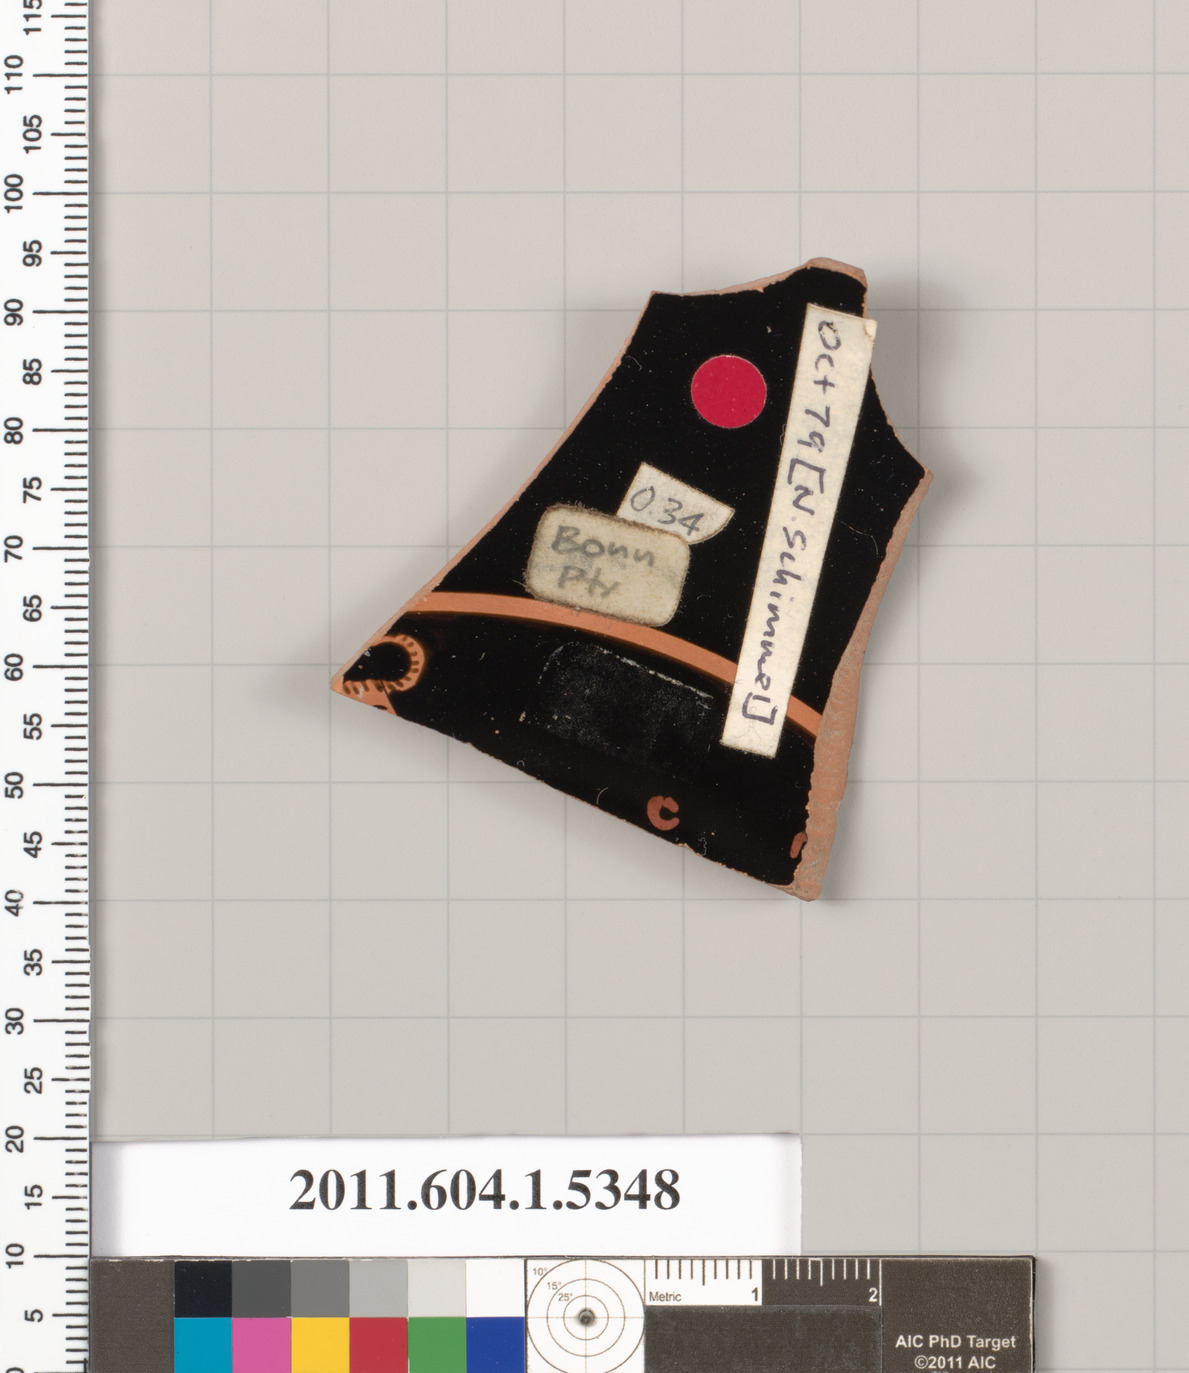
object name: kylix fragment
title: Terracotta fragment of a kylix (drinking cup)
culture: greek, attic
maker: bonn painter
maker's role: artist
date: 500-480 BCE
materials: terracotta